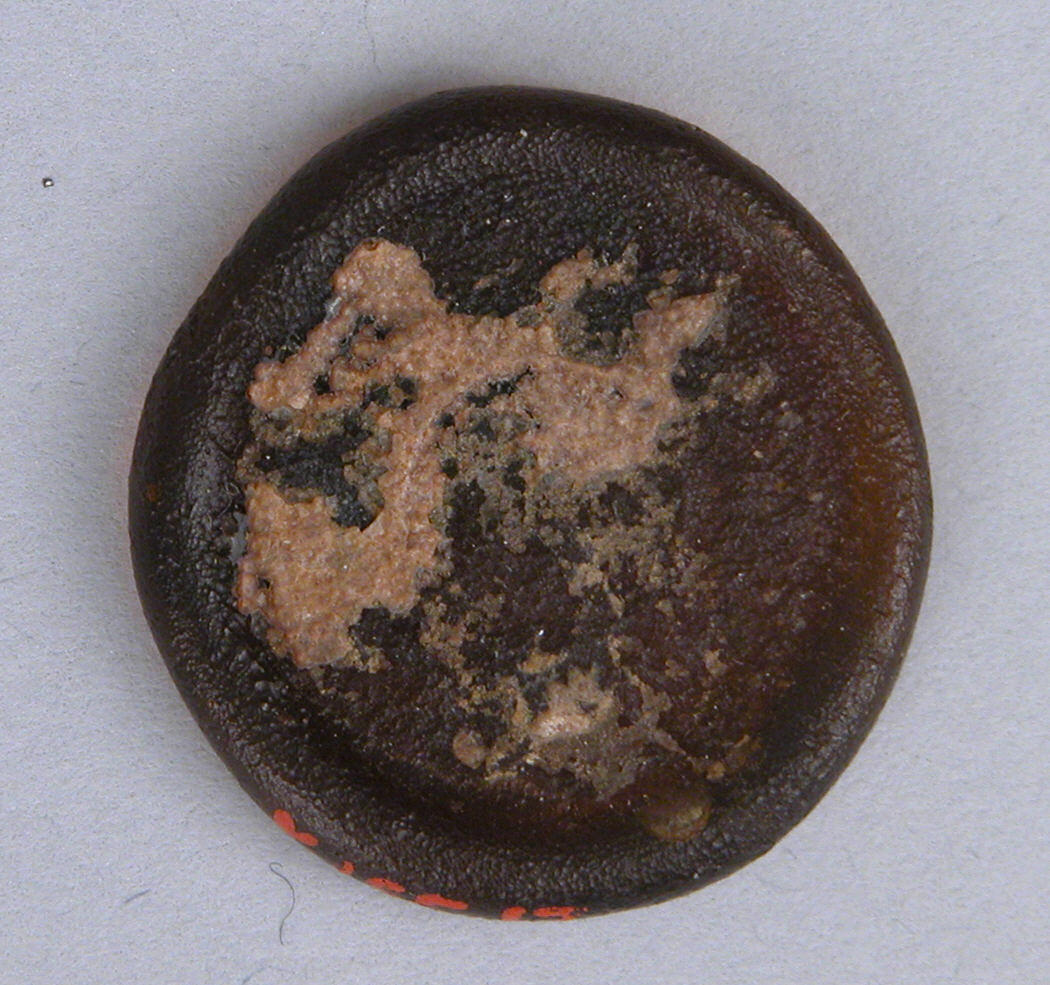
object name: coin weight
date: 1001-1100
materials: glass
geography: egypt